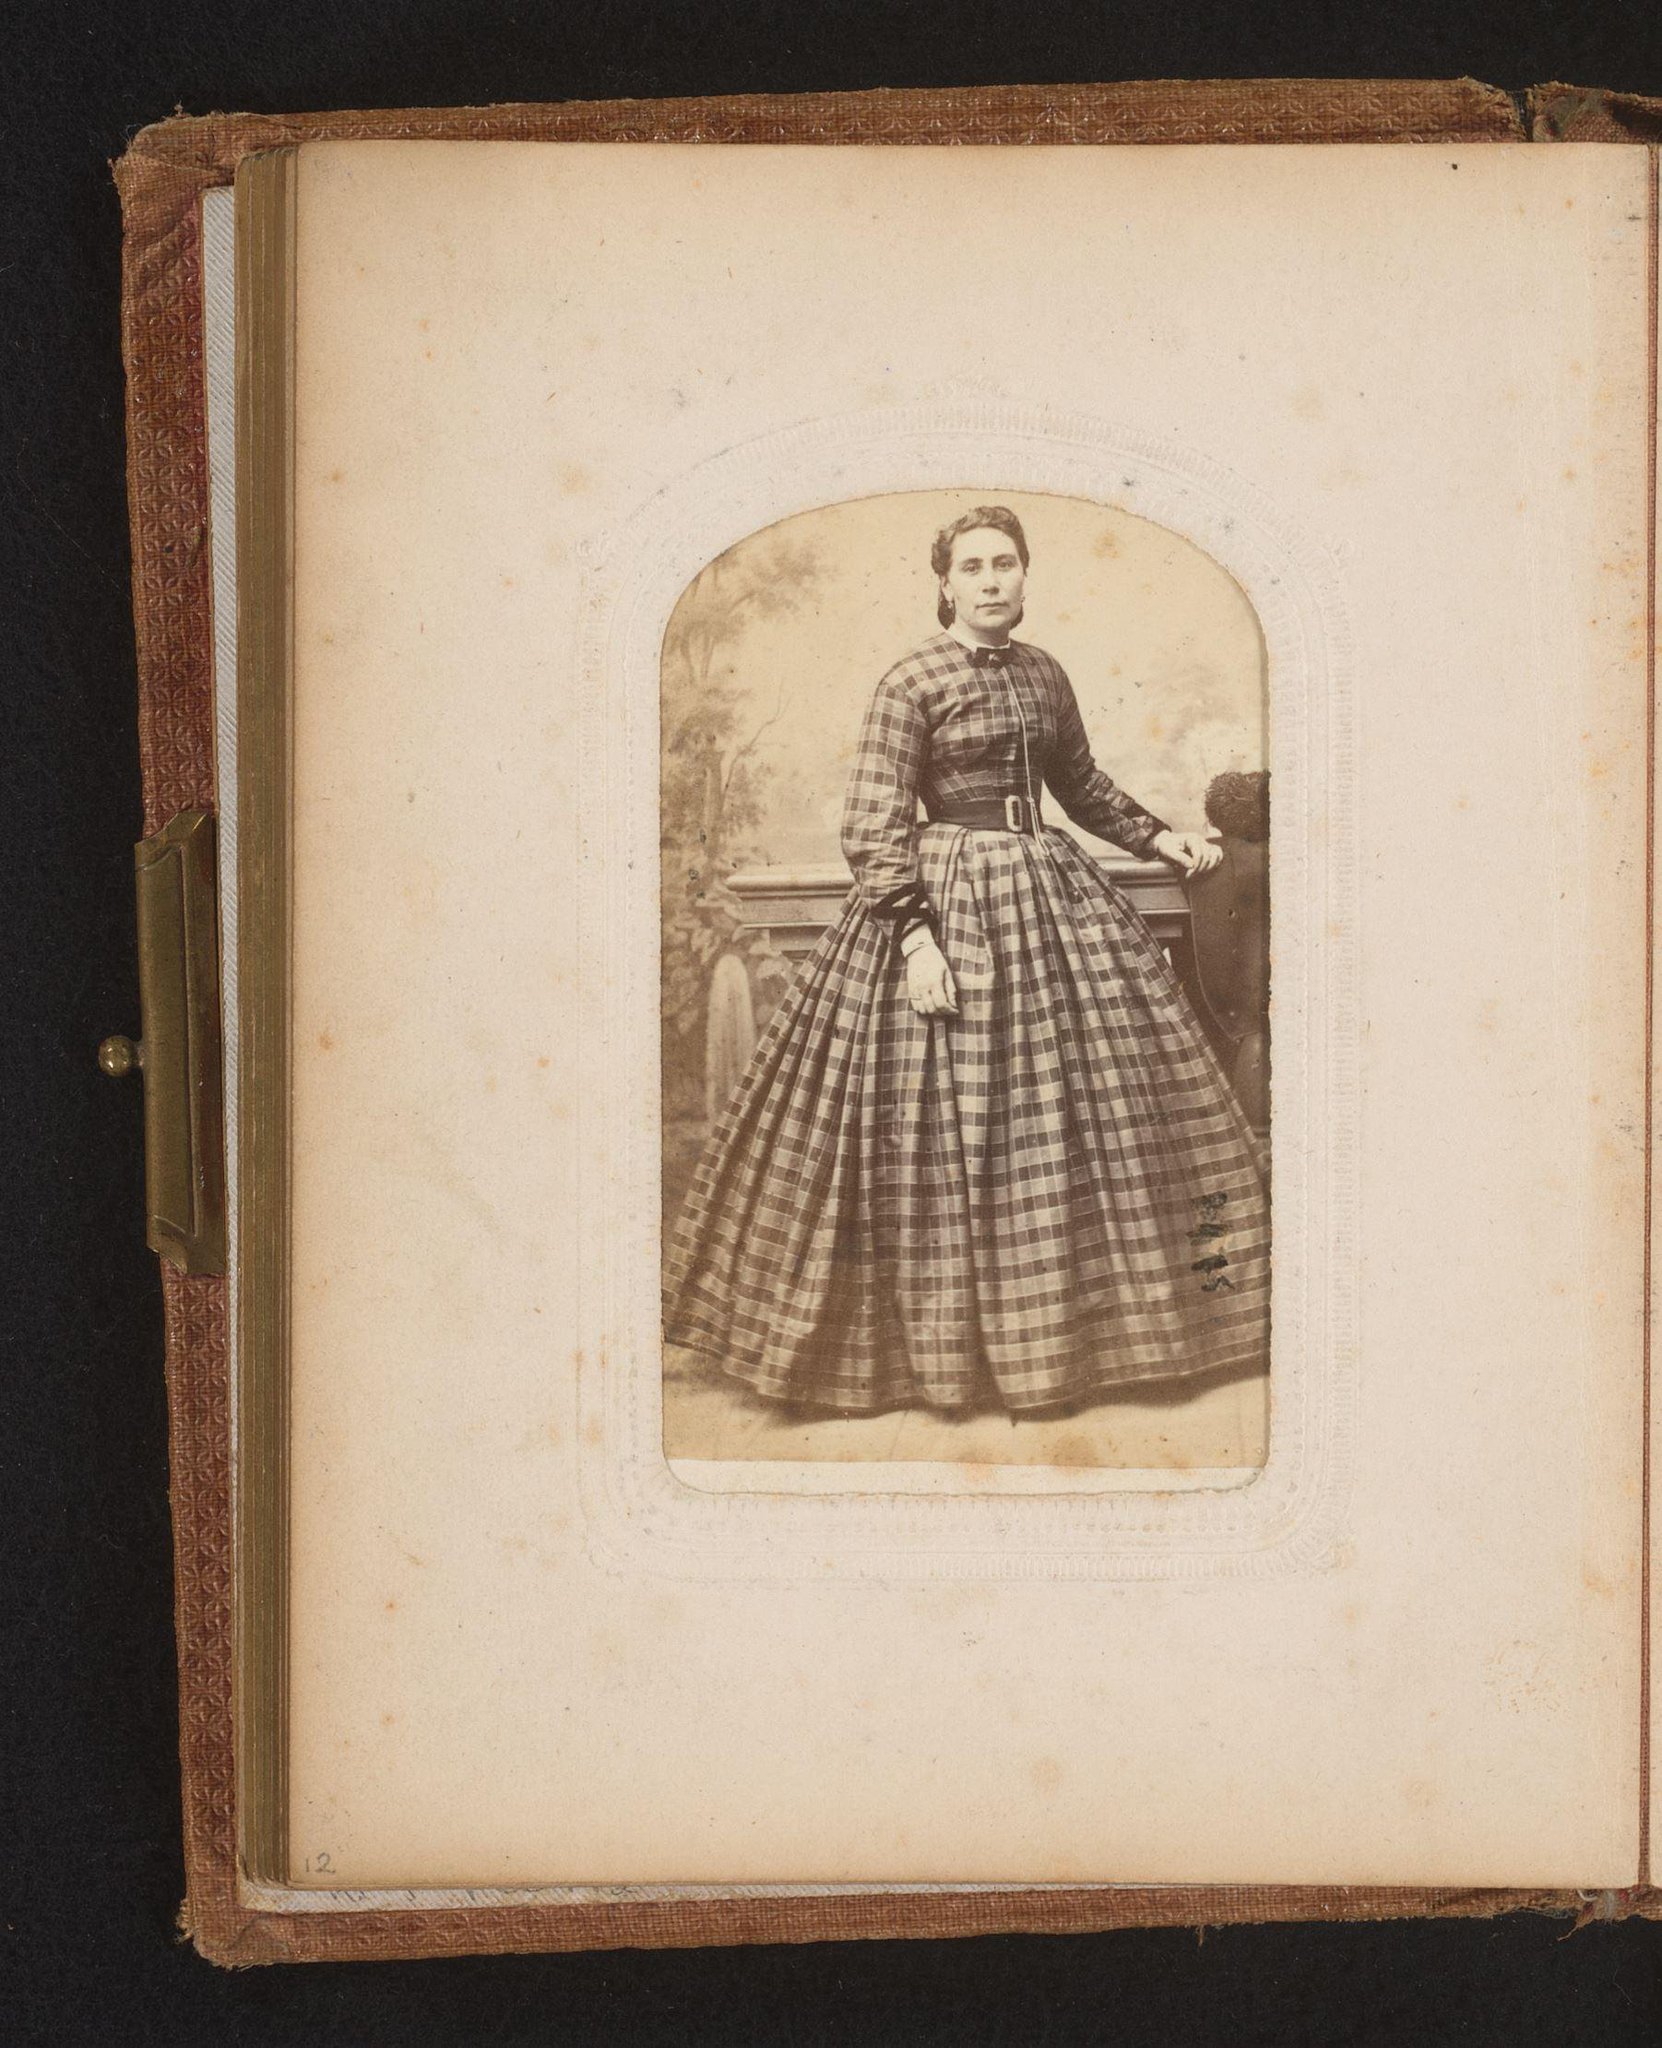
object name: carte de visite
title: Portret van een vrouw, staand bij een balustrade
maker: christian dannhof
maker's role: fotograaf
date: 1860-1900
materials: cardboard, photographic support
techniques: albumen print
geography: bad homburg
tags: historical persons - bb - woman, balustrade, standing figure - aa - female human figure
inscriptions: inscription: ‘PHOTOGRAPHISCHE ANSTALT/ von/ Christian Dannhof/ BAD HOMBURG./ Untere Promenade No. 19.’